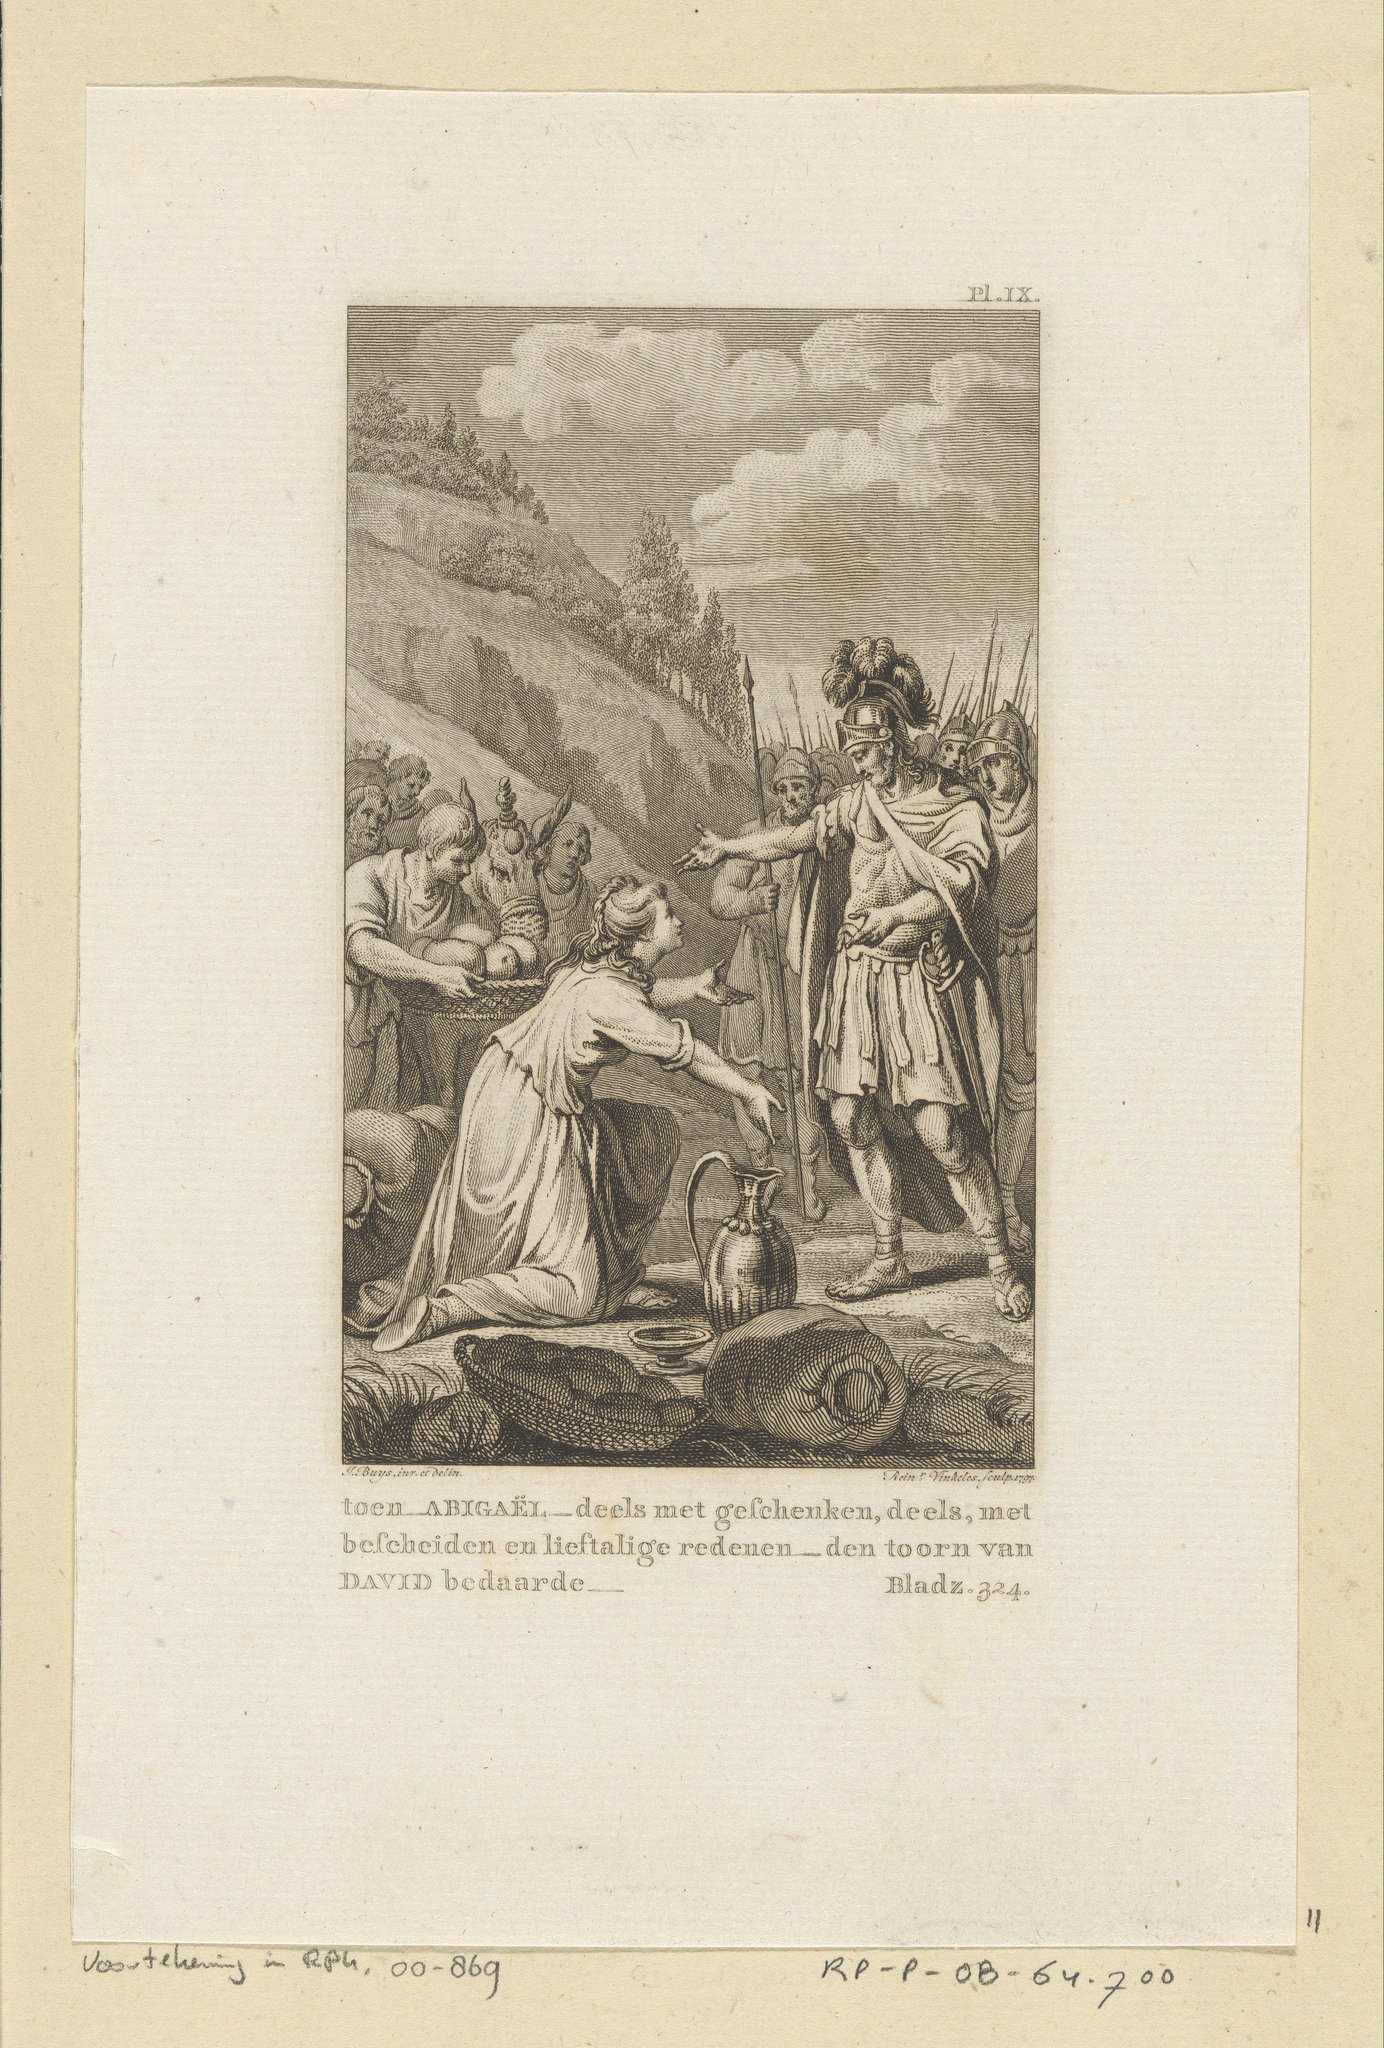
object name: print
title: toen Abigaël deels met geschenken, deels, met bescheiden en lieftalige redenen den toorn van David bedaarde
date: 1797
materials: paper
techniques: engraving, etching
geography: amsterdam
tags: meeting of david and abigail, who kneels before him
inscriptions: collector's mark: Lugt 240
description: Wanneer een gierige boer weigert David en zijn manschappen te helpen, dreigen ze hem te straffen. Abigaïl, de vrouw van de boer, knielt voor David en biedt hem en zijn soldaten eten en drinken aan. Daarmee stemde ze David tevreden.